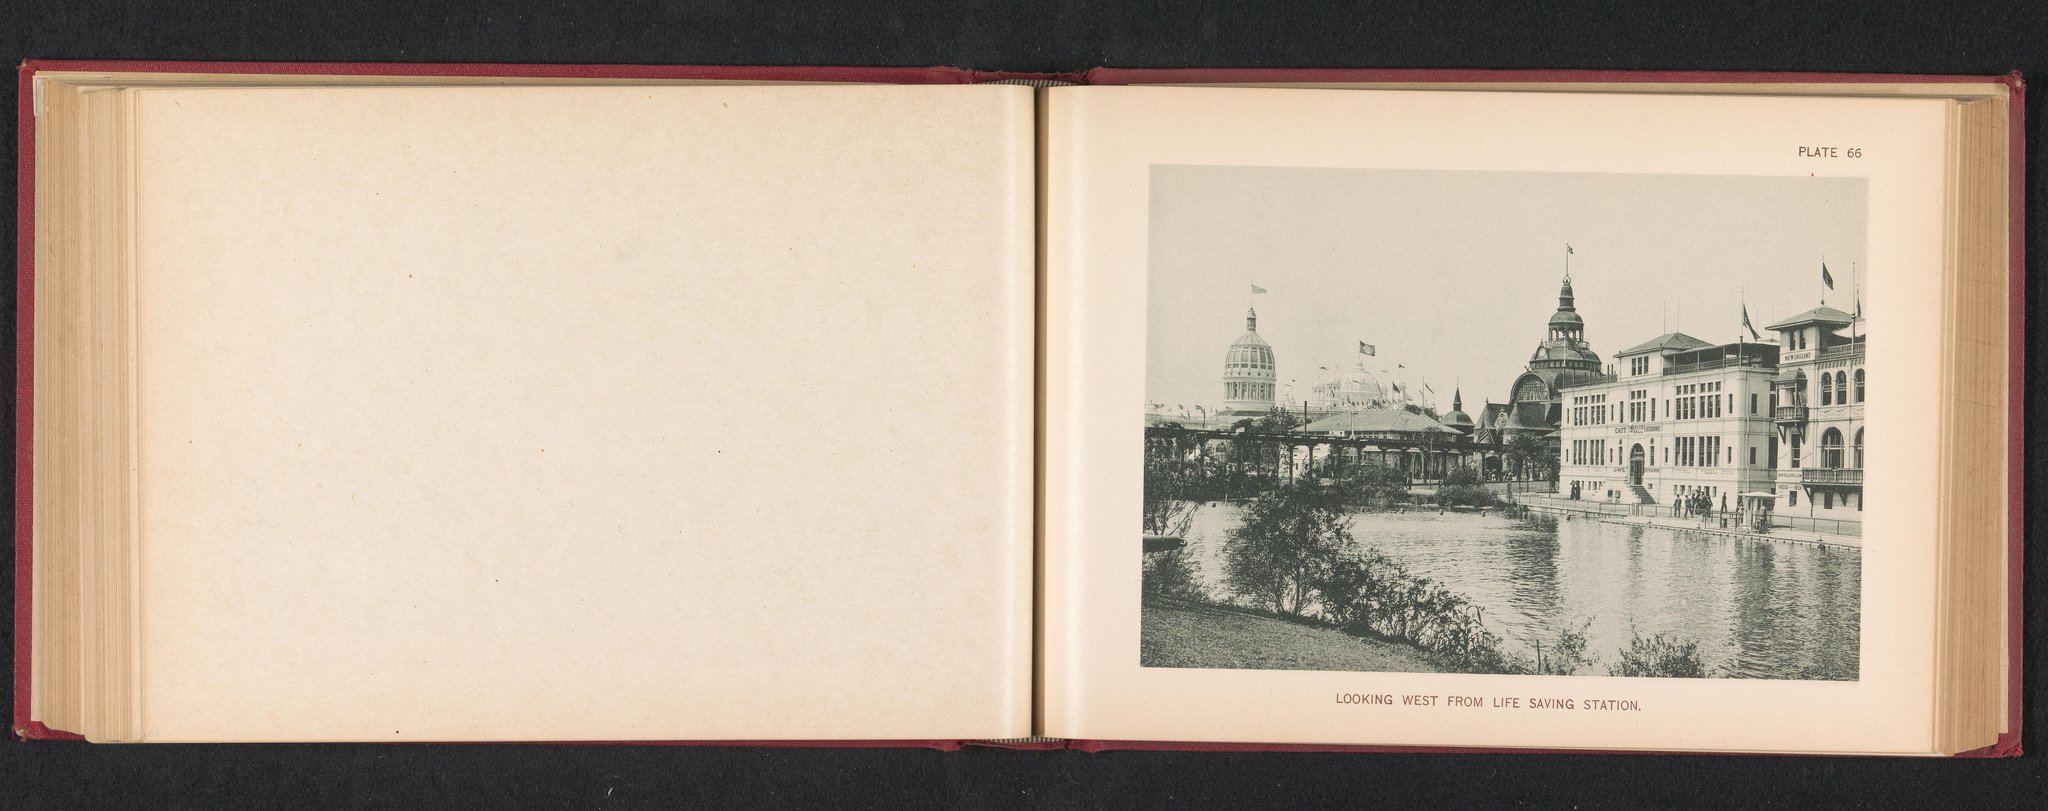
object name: page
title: Looking west from Life Saving Station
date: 1893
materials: paper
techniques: photograph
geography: chicago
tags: world fair, world exhibition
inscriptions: number: ‘Plate 66’